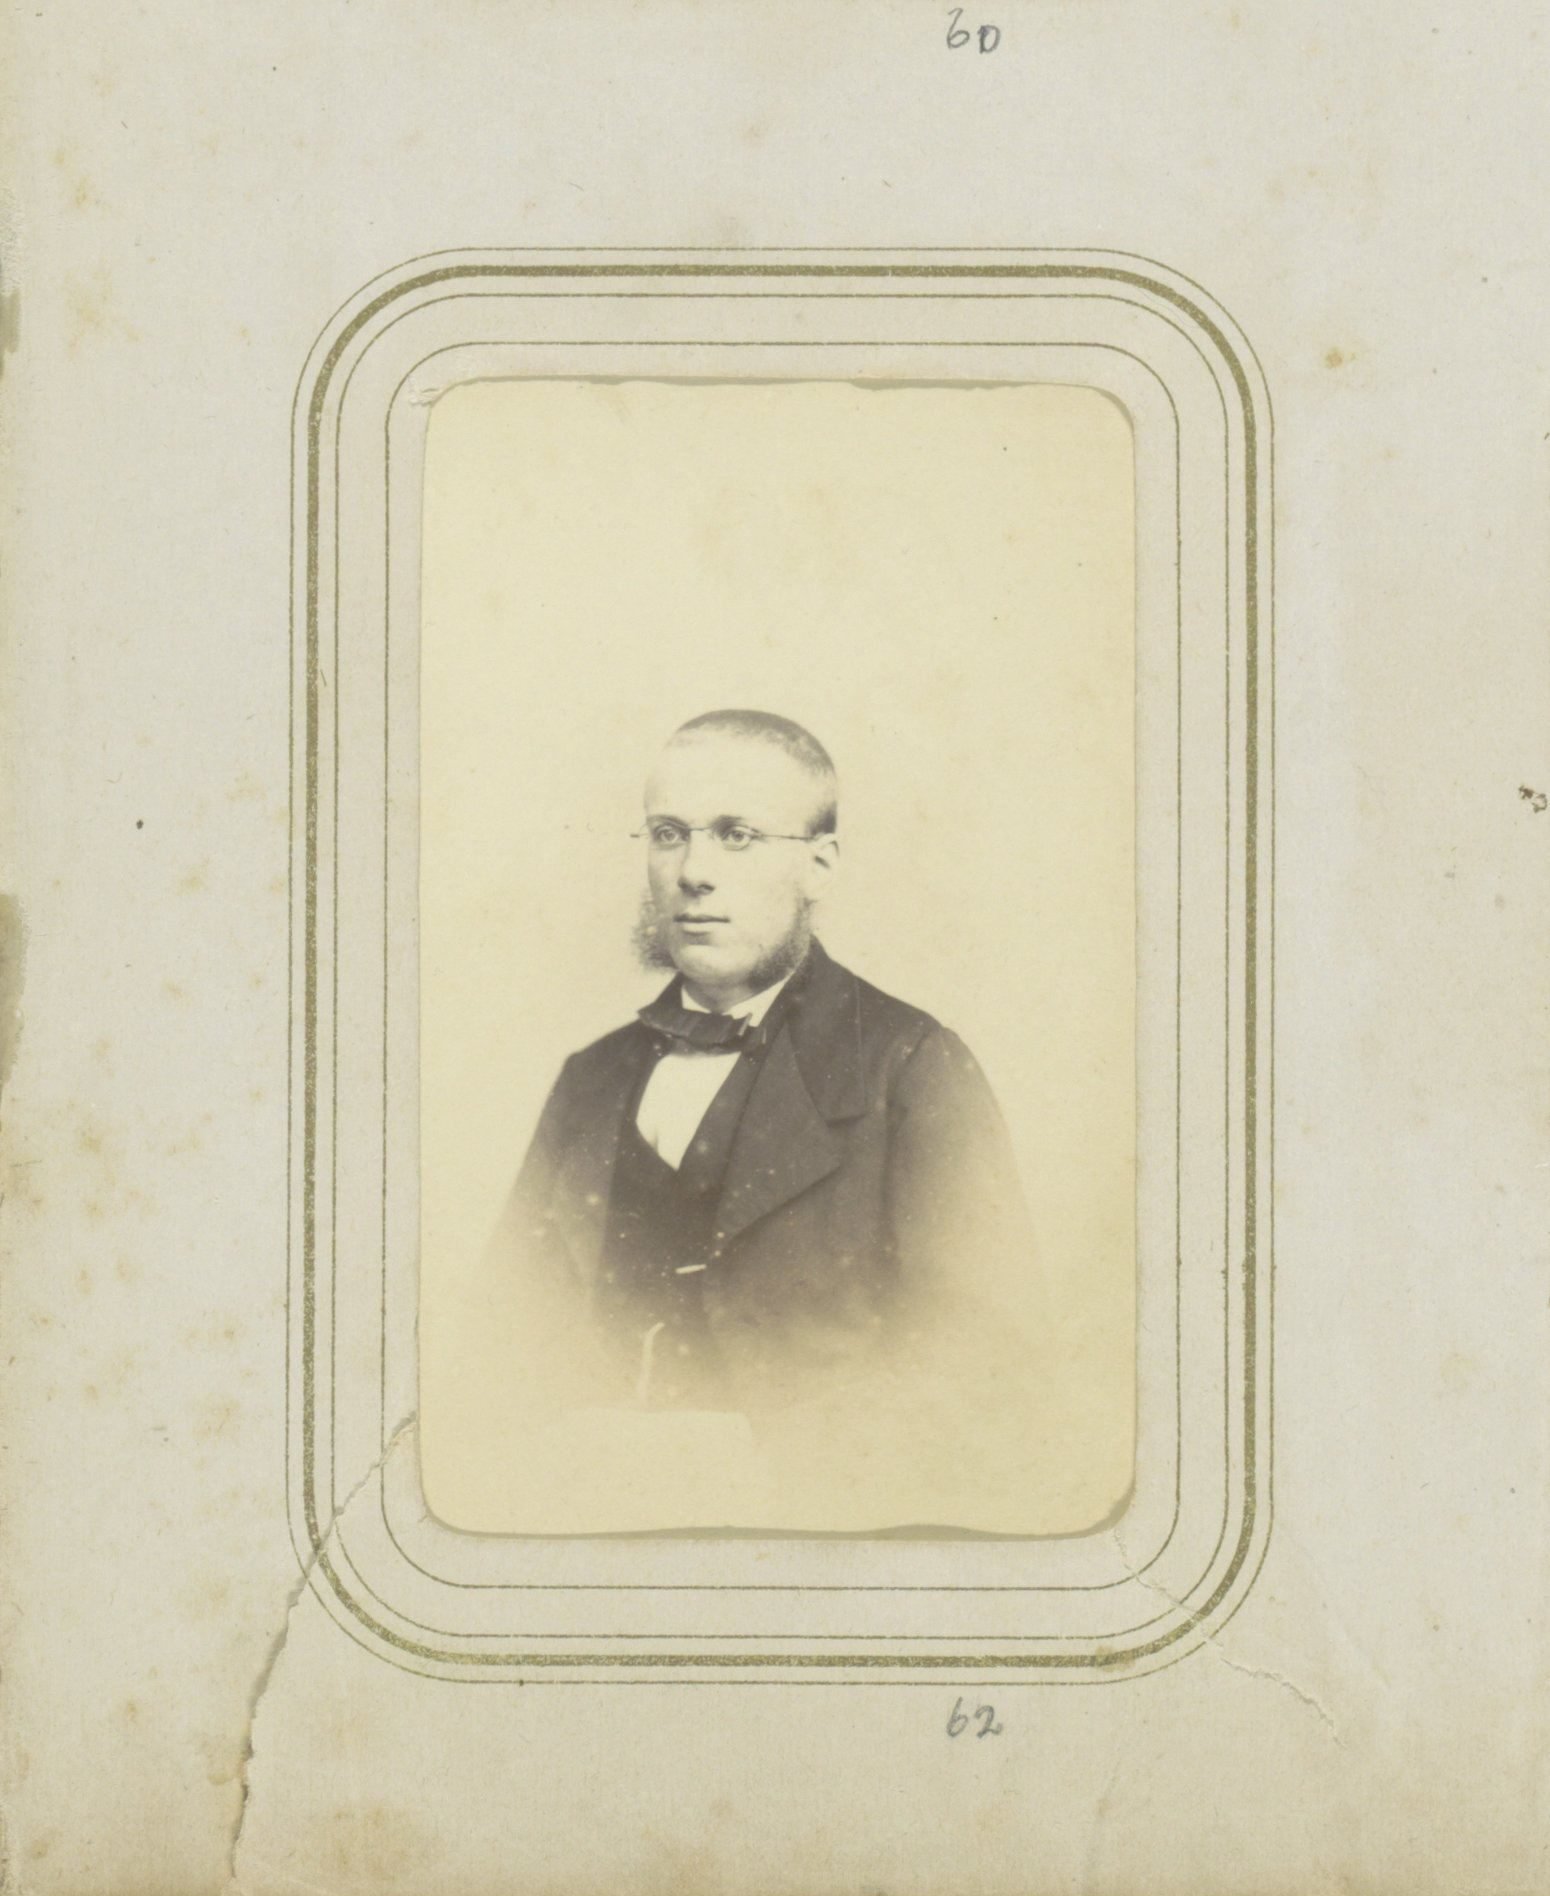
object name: carte de visite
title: Portret van een jongeman met bril, kort haar en bakkebaarden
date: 1865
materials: cardboard, photographic support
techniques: albumen print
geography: batavia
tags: eyeglasses, spectacles, sideburns, historical persons, neck-gear ~ clothing, clothing for the upper part of the body, family, relationship, descent, hairdress, batavia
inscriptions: address: ‘Java’, inscription: ‘[...] Batavia 17/3/65.’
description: Onderdeel van Familiealbum van H.W.F. Ligtenberg en L.M. Swart met 149 foto's en cartes-de-visite.